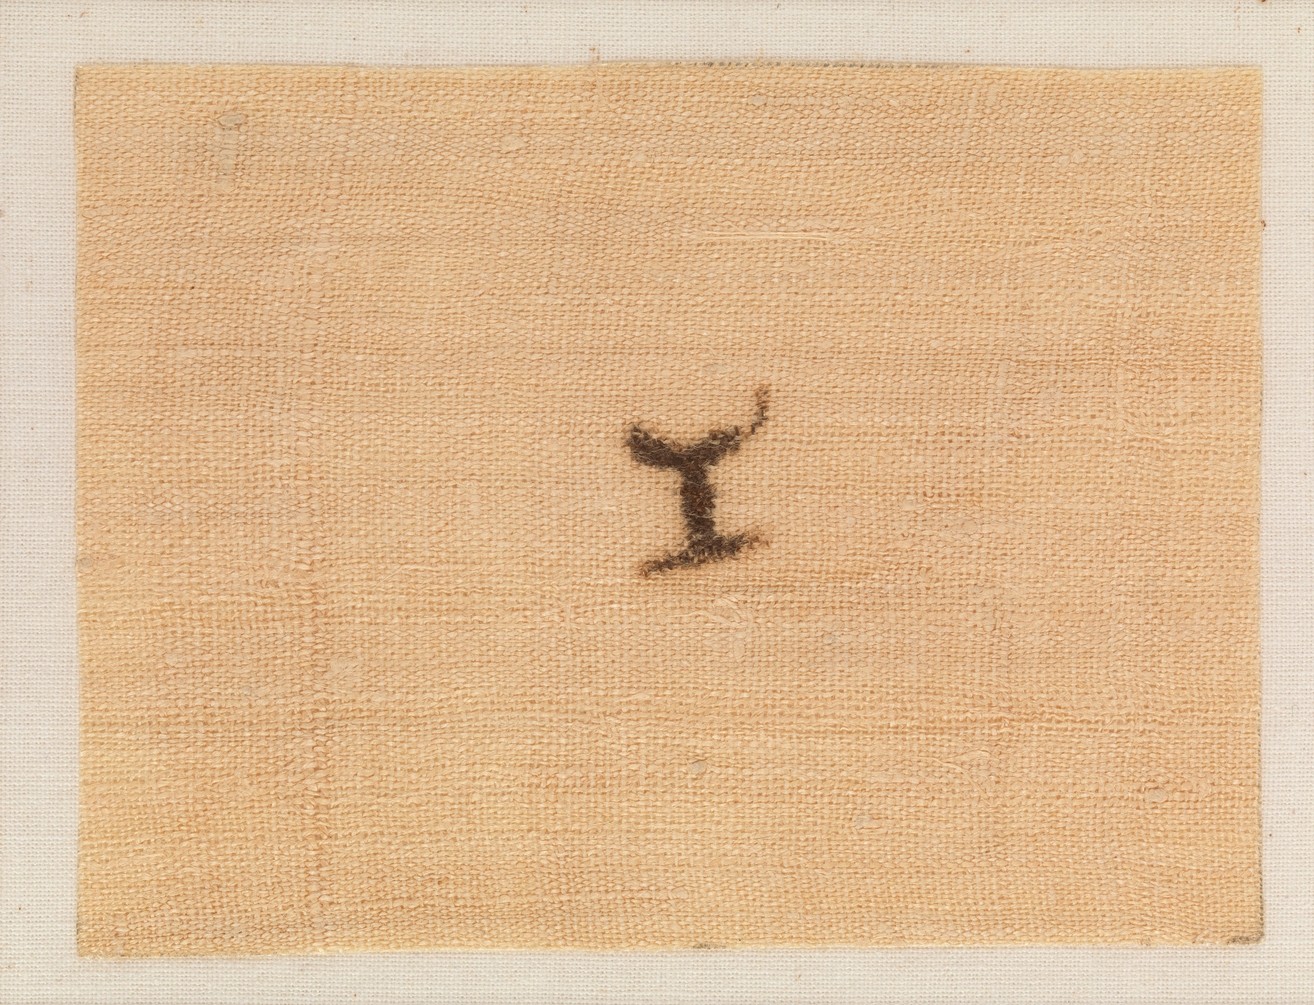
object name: linen mark, wah, 20. 3. 203ttt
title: Linen Mark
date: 1981-1975 BCE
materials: linen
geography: egypt